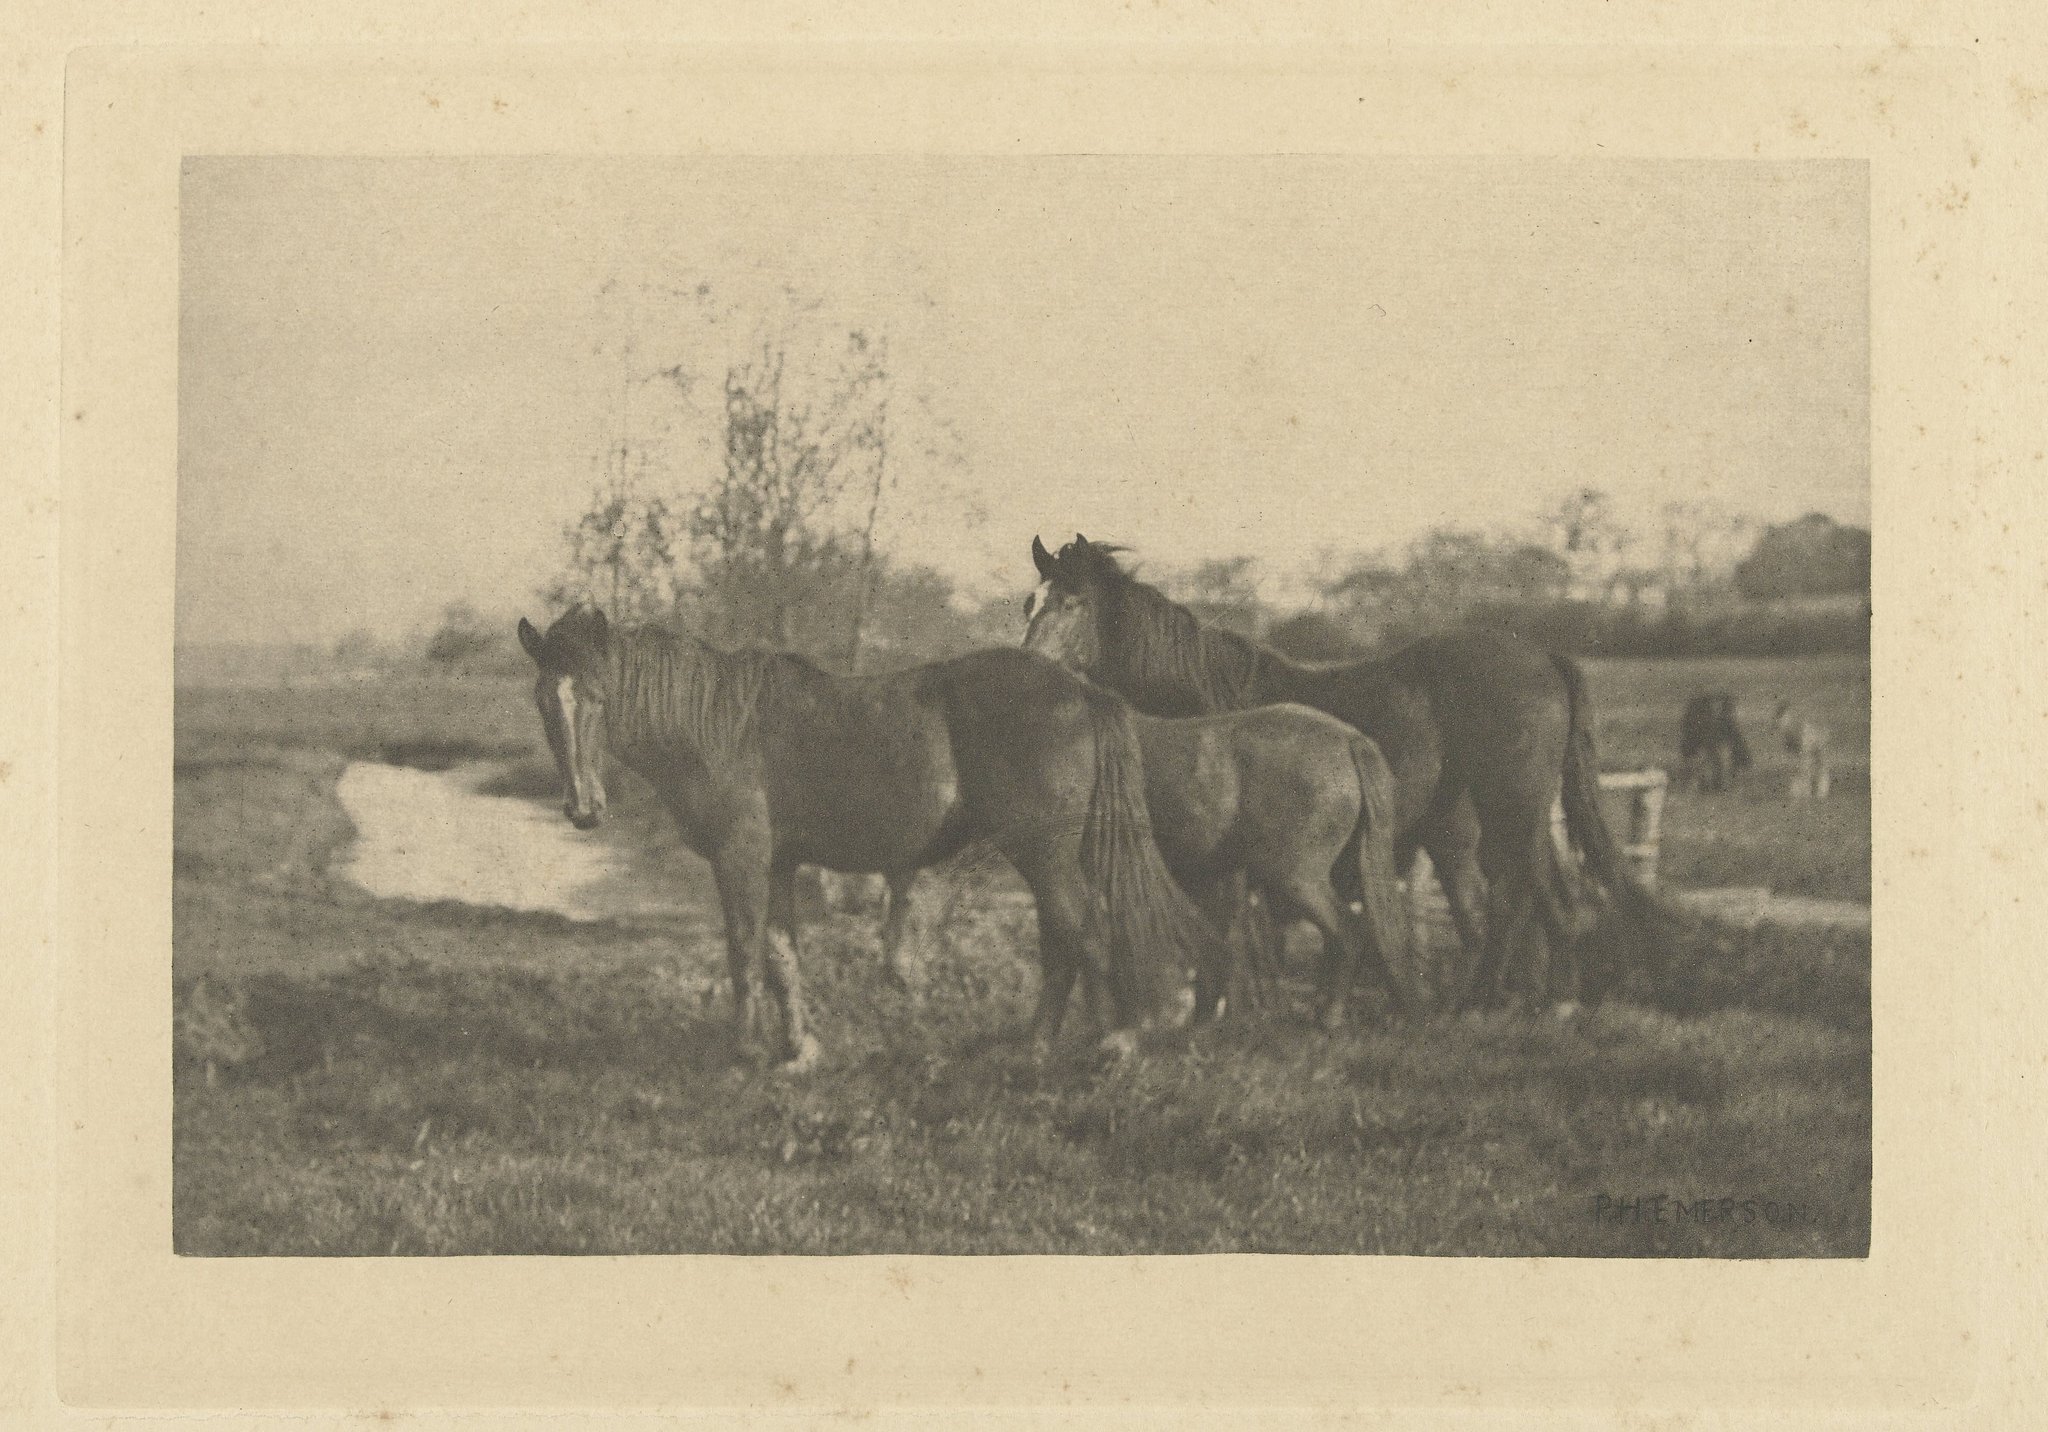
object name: photomechanical print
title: Colts on a Norfolk Marsh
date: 1883-1888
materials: paper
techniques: photoaquatint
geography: great britain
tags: horse